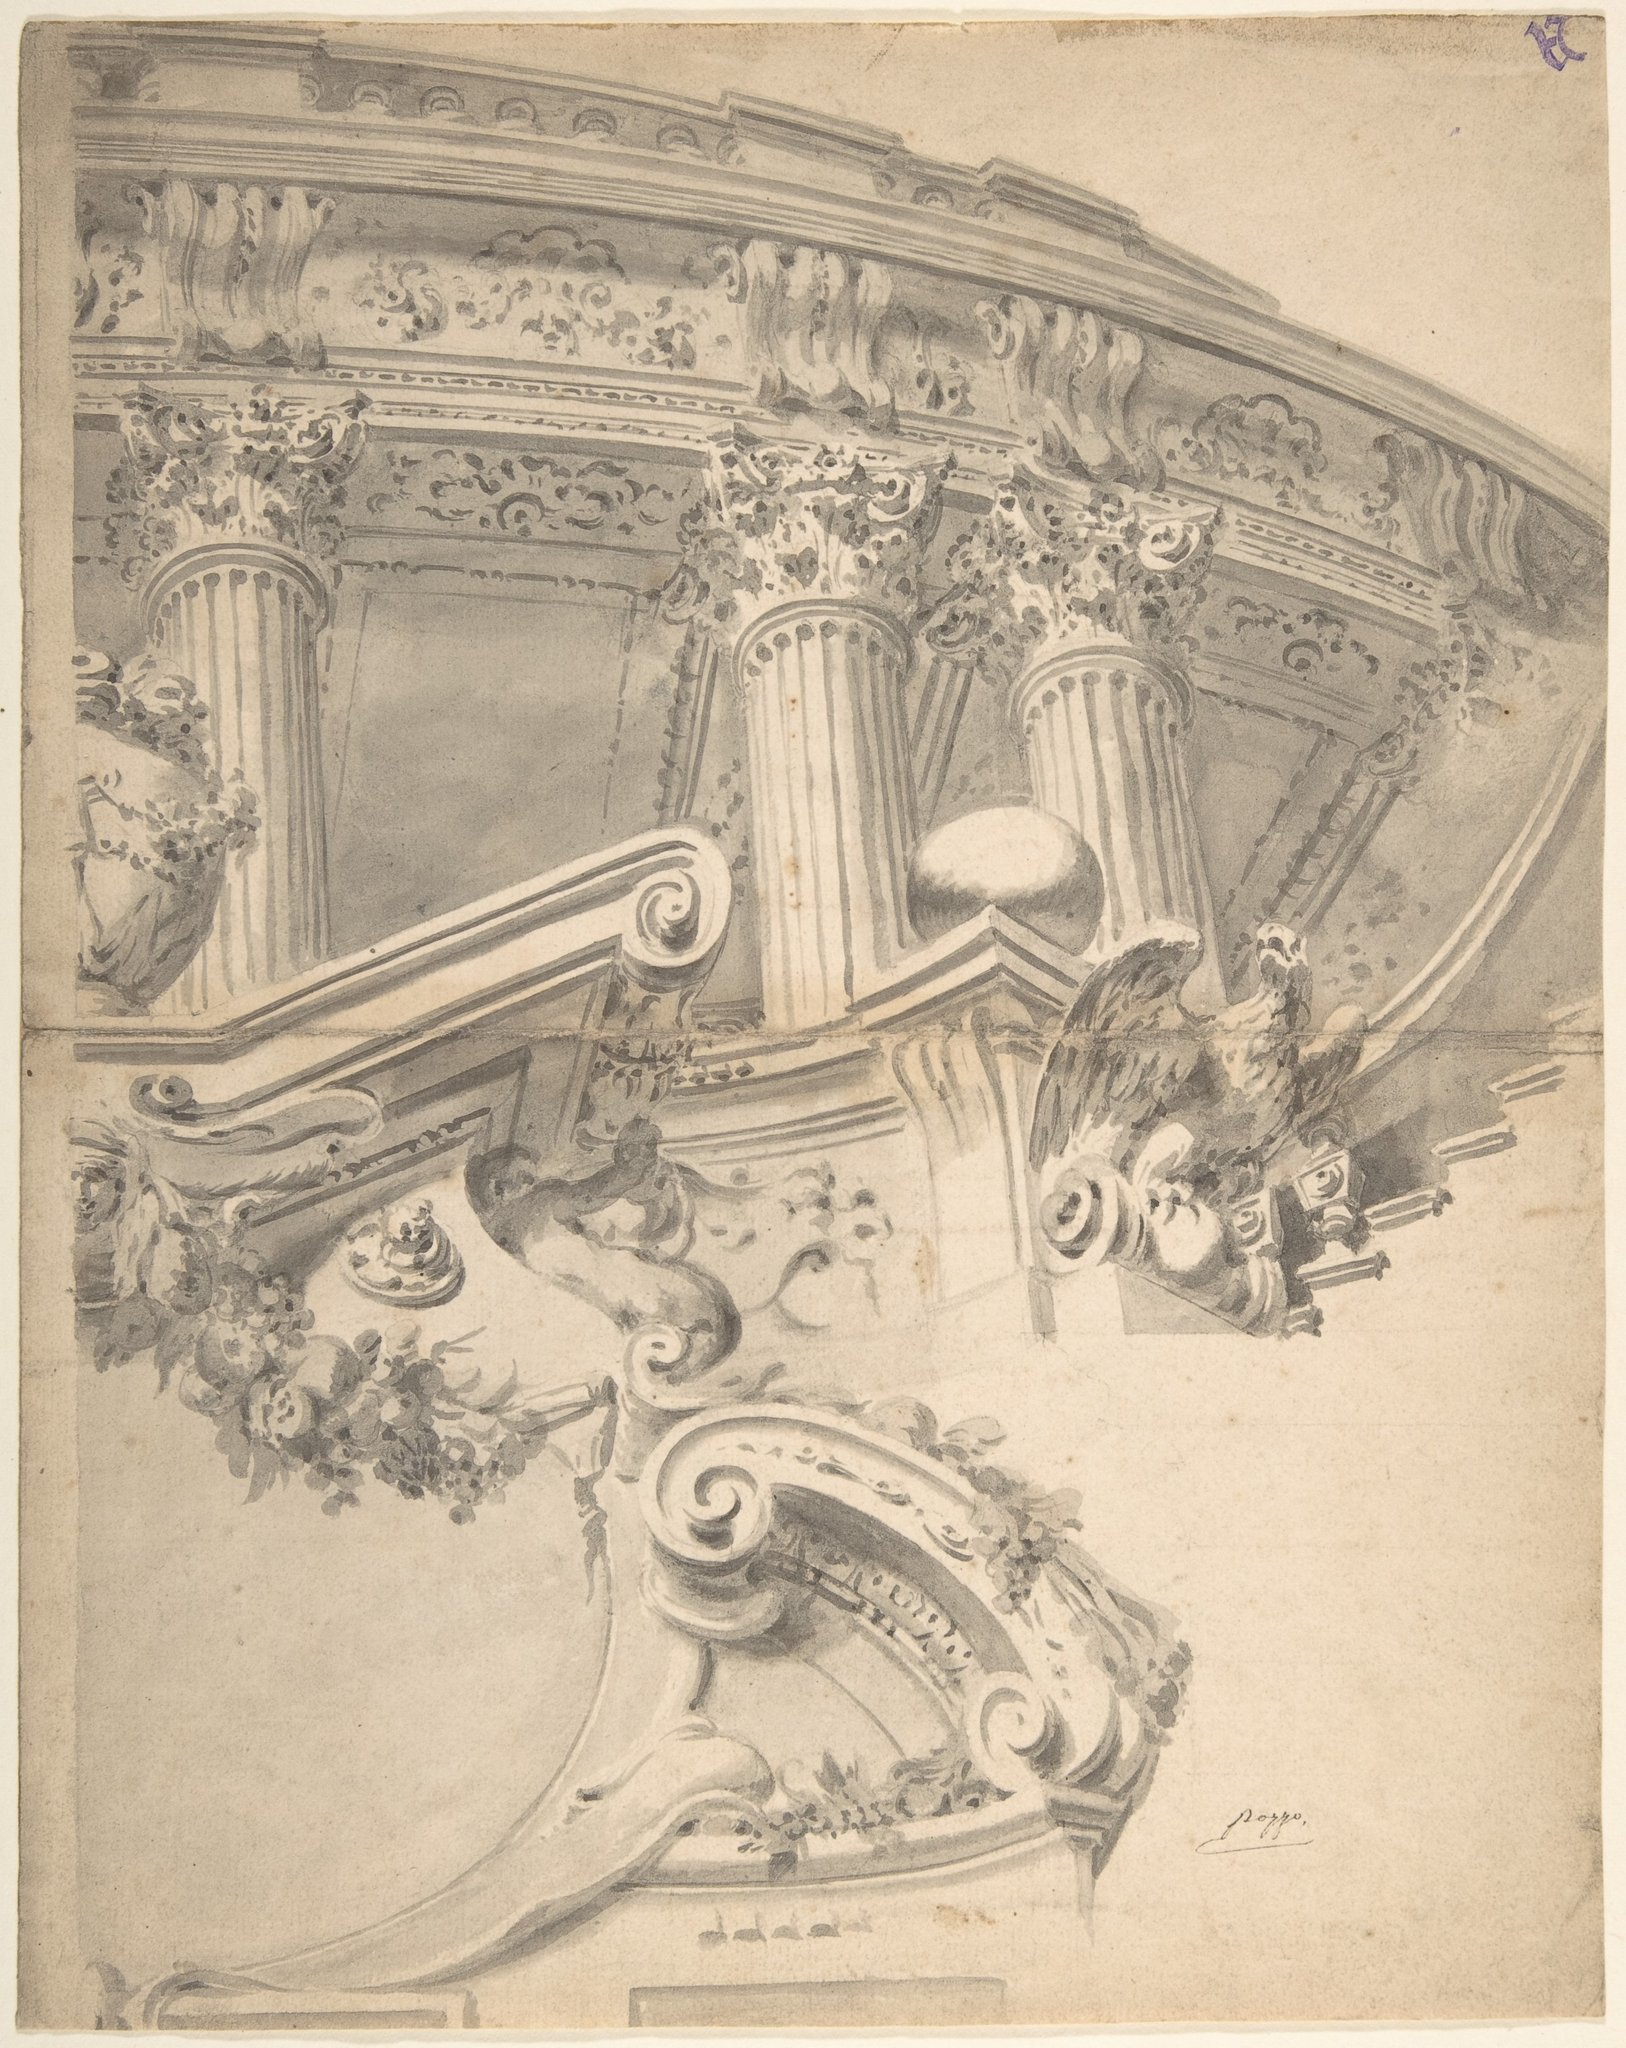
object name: drawing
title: Architectural Capriccio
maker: anonymous, italian, 18th century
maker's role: artist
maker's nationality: italian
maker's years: 1700-1800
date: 1701-1800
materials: ink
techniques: pen, wash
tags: architecture,columns